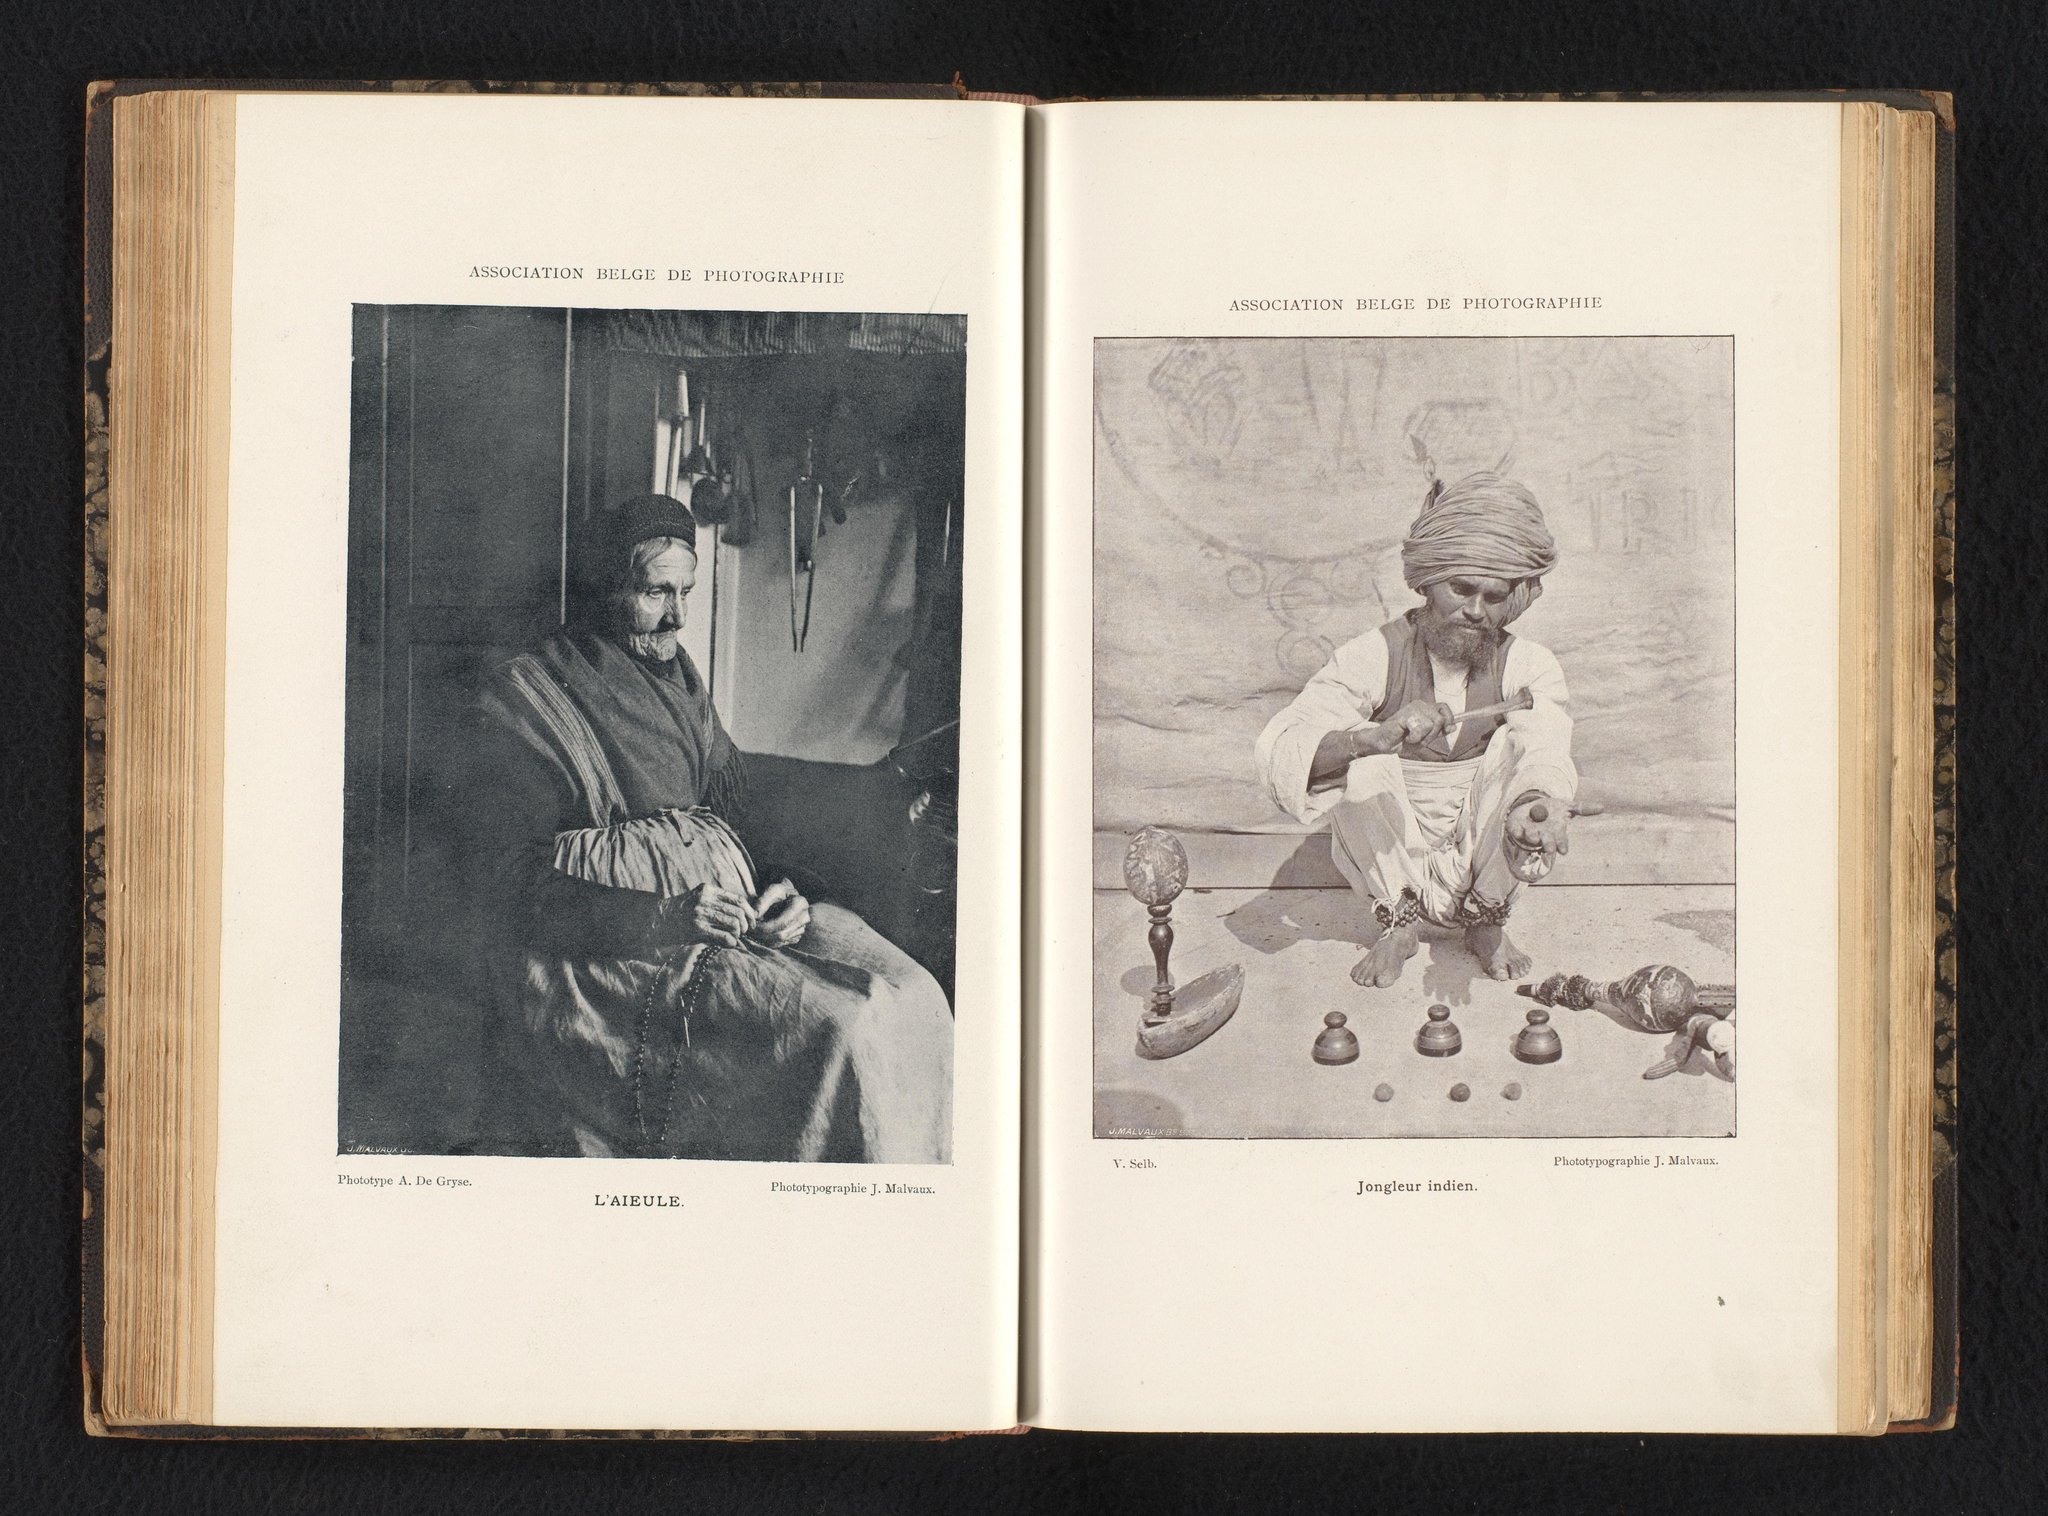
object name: page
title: Jongleur indien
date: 1893-1898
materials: paper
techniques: autotype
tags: illusionist, conjurer, juggler, 'legerdemain', adult man, historical persons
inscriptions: inscription: ‘Association belge de photographie’